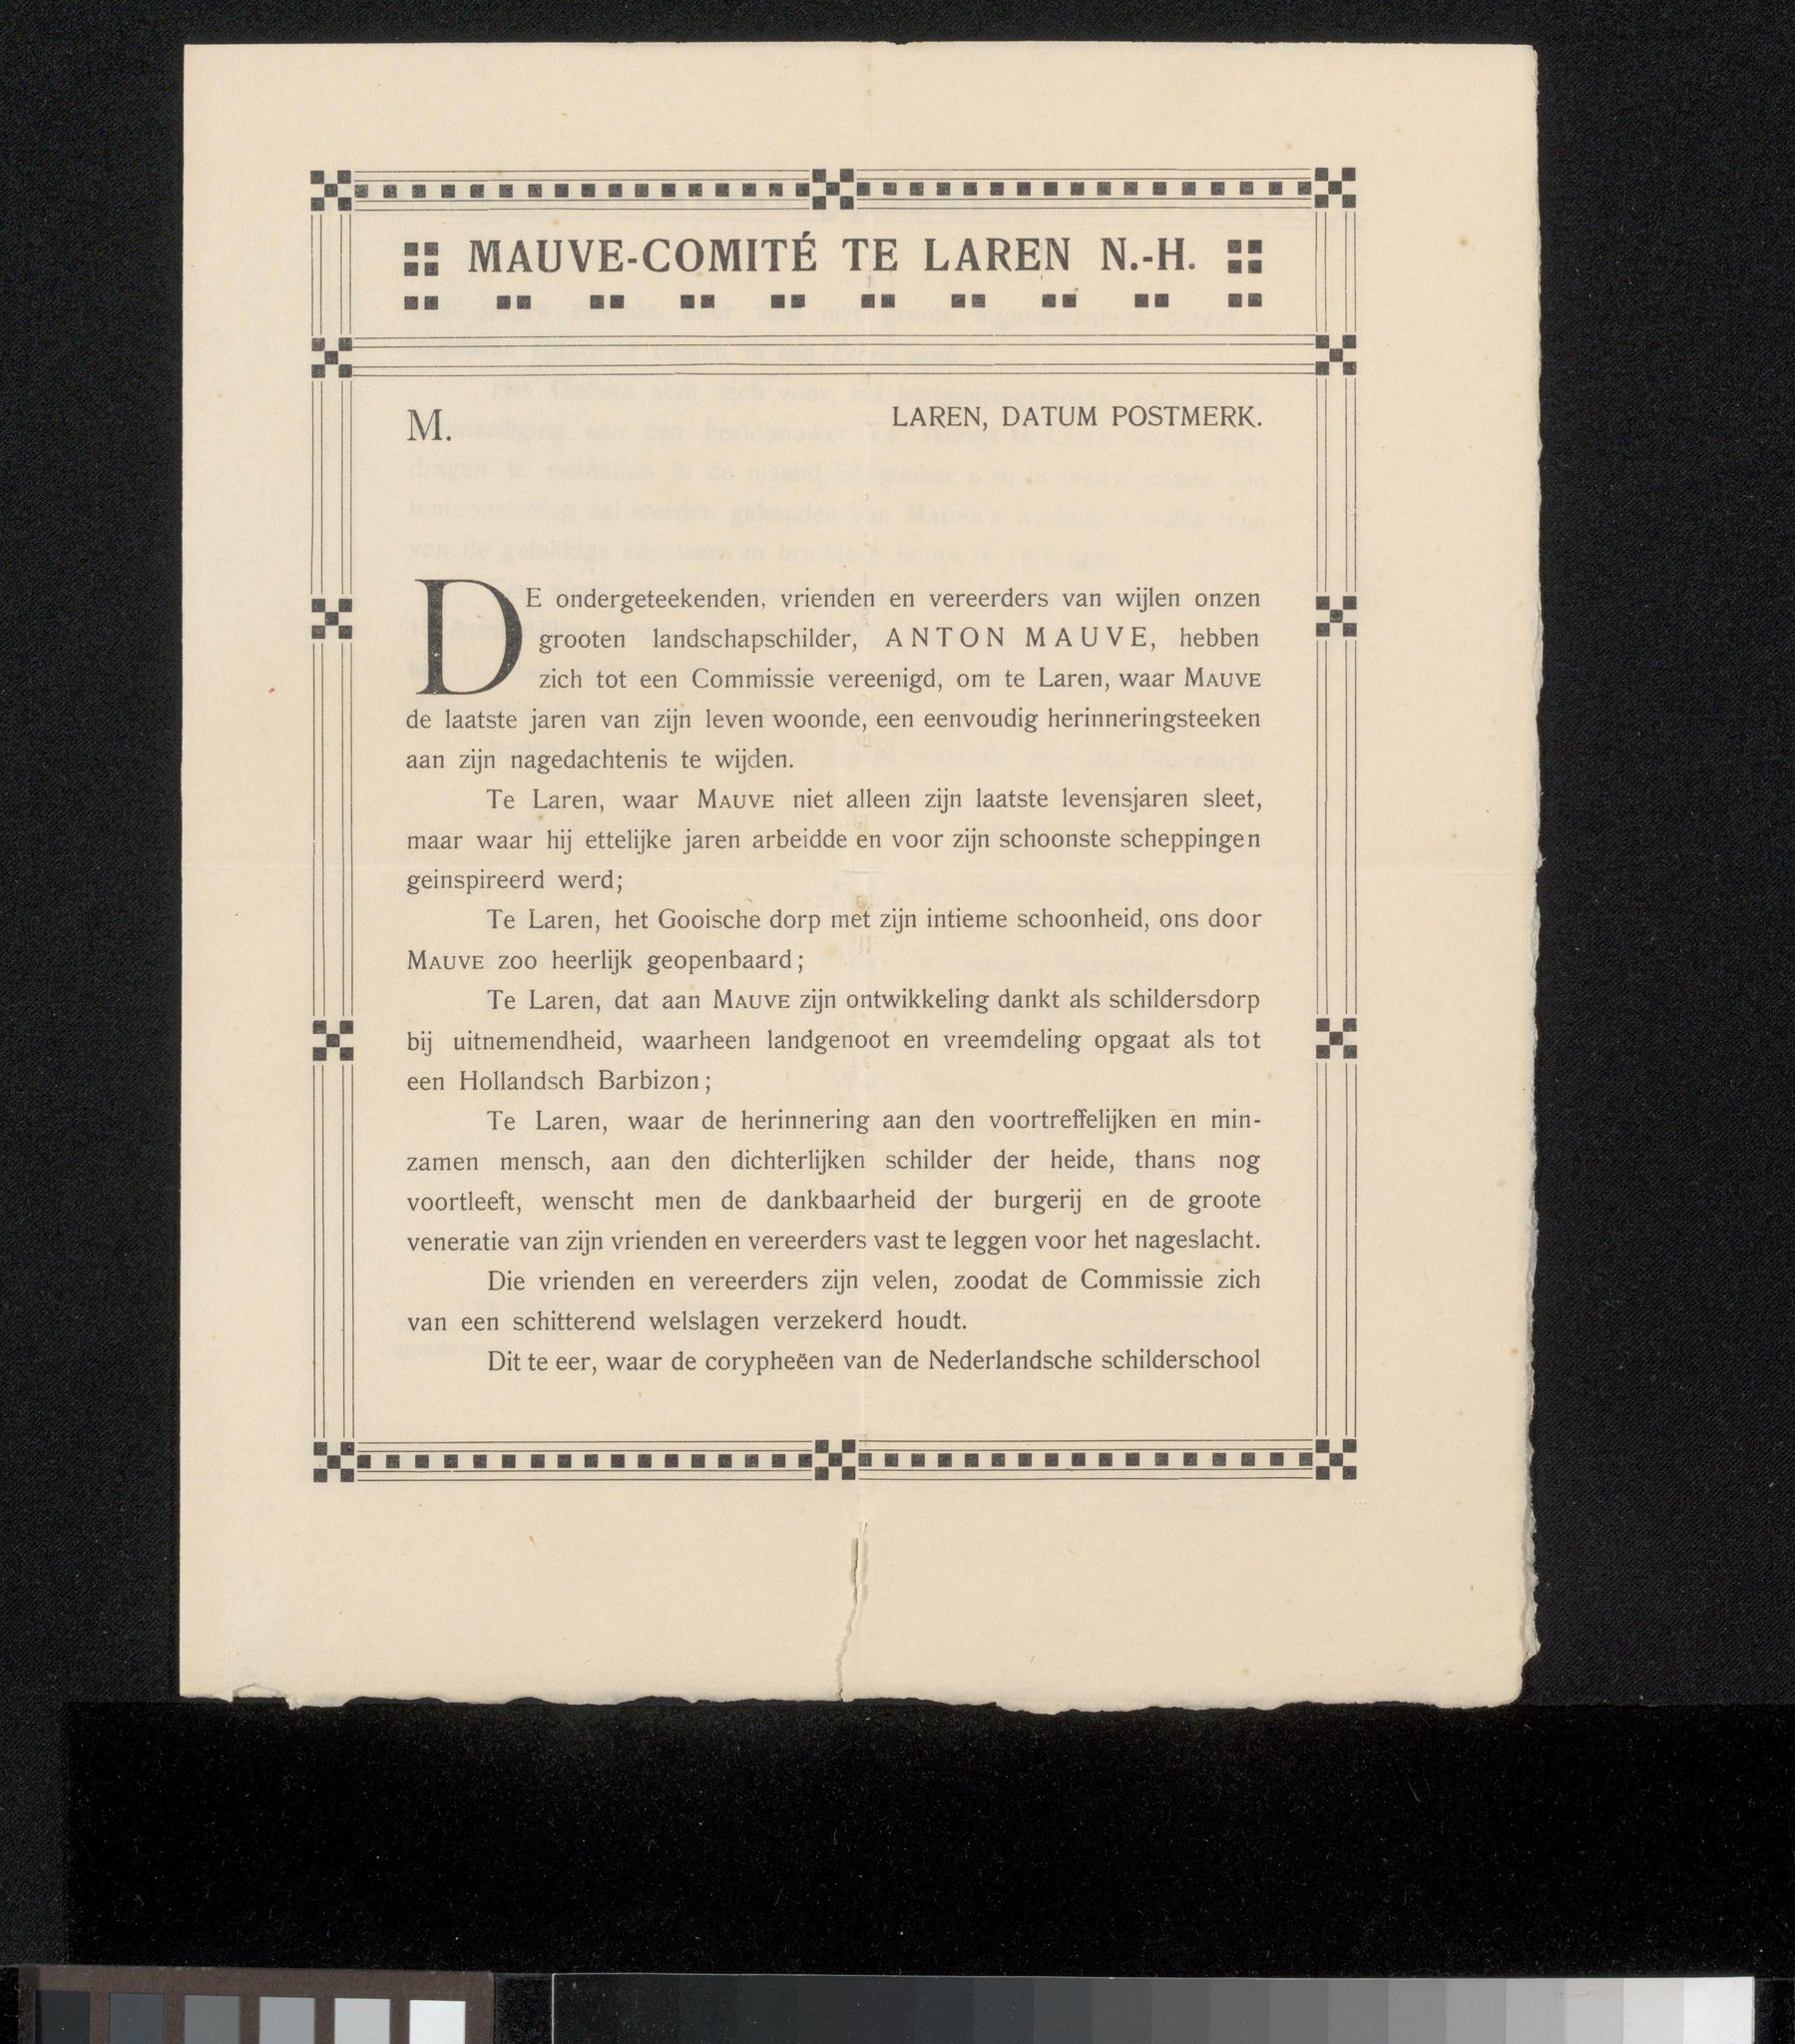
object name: letter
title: Brief aan Philip Zilcken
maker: nico van harpen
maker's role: kunsthandelaar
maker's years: 1858-1931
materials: paper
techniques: printing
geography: laren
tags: arnhem, print maker, anton mauve, sculptor, the hague, painter, draughtsman, philip zilcken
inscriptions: watermark, collector's mark: ‘RPK’